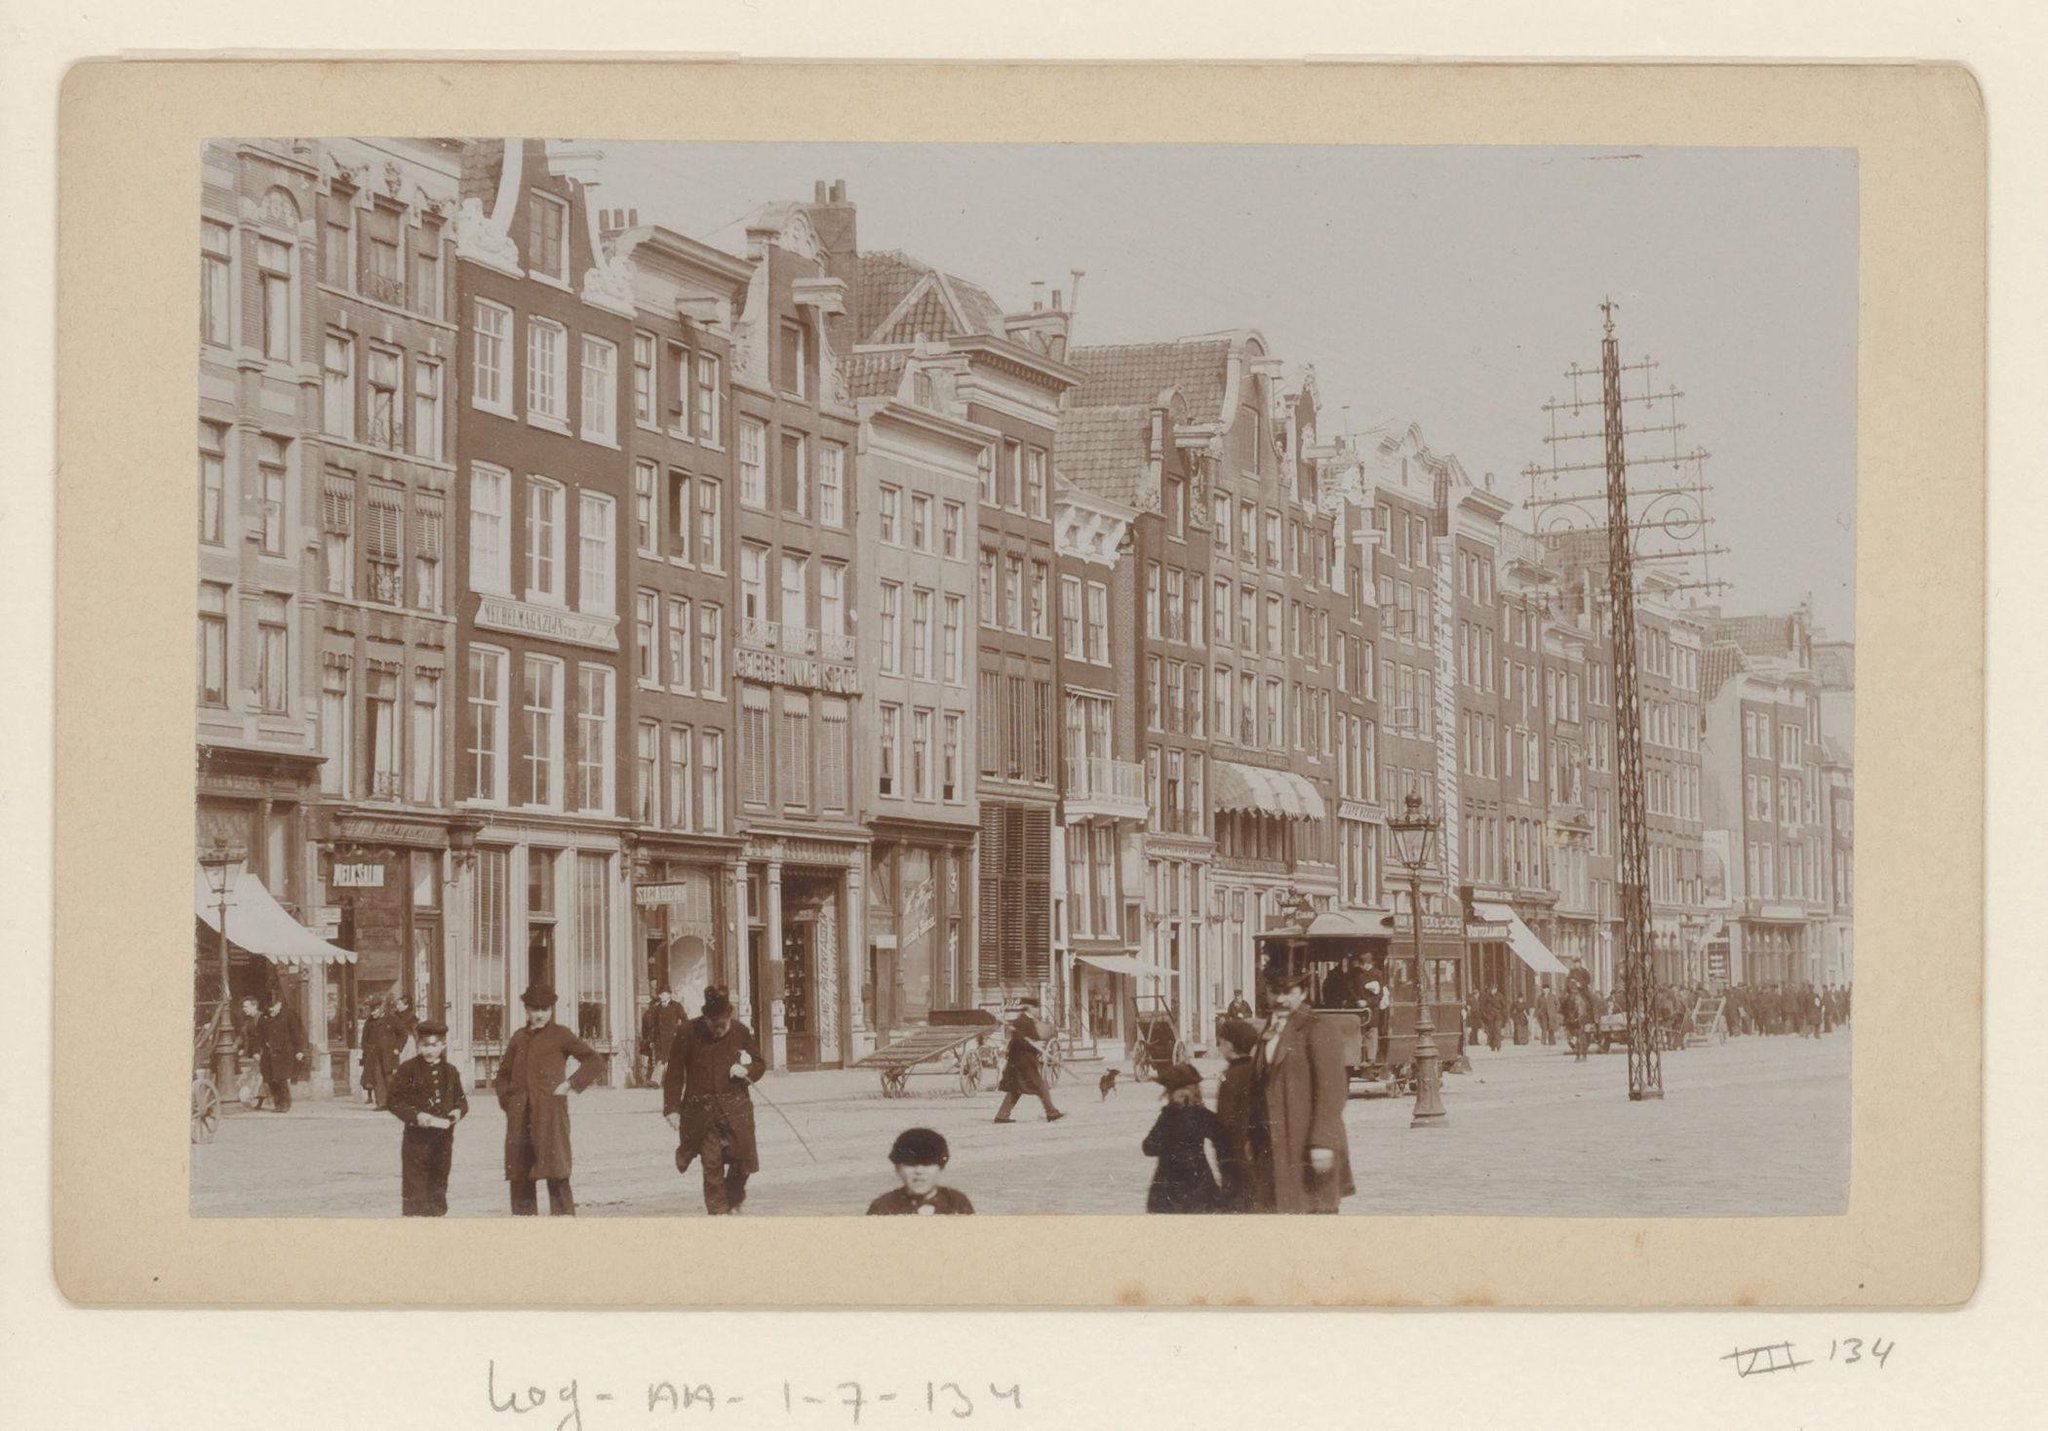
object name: cabinet photograph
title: Gezicht op het Damrak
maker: Anonymous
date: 1880-1920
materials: paper, cardboard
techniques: collodion silver print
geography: amsterdam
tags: city-view in general; 'veduta', street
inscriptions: collector's mark: ‘7’ Lugt 1641b, inscription: ‘No 9 Damrak’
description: Onderwerpsrubriek binnen de Atlas Amsterdam: Damrak, Damstraat, Doelensluis, Doelenstraat (Nieuwe), Driehoekstraat, Droogbak, Duvelshoek, Dijkstraat en Korte -.